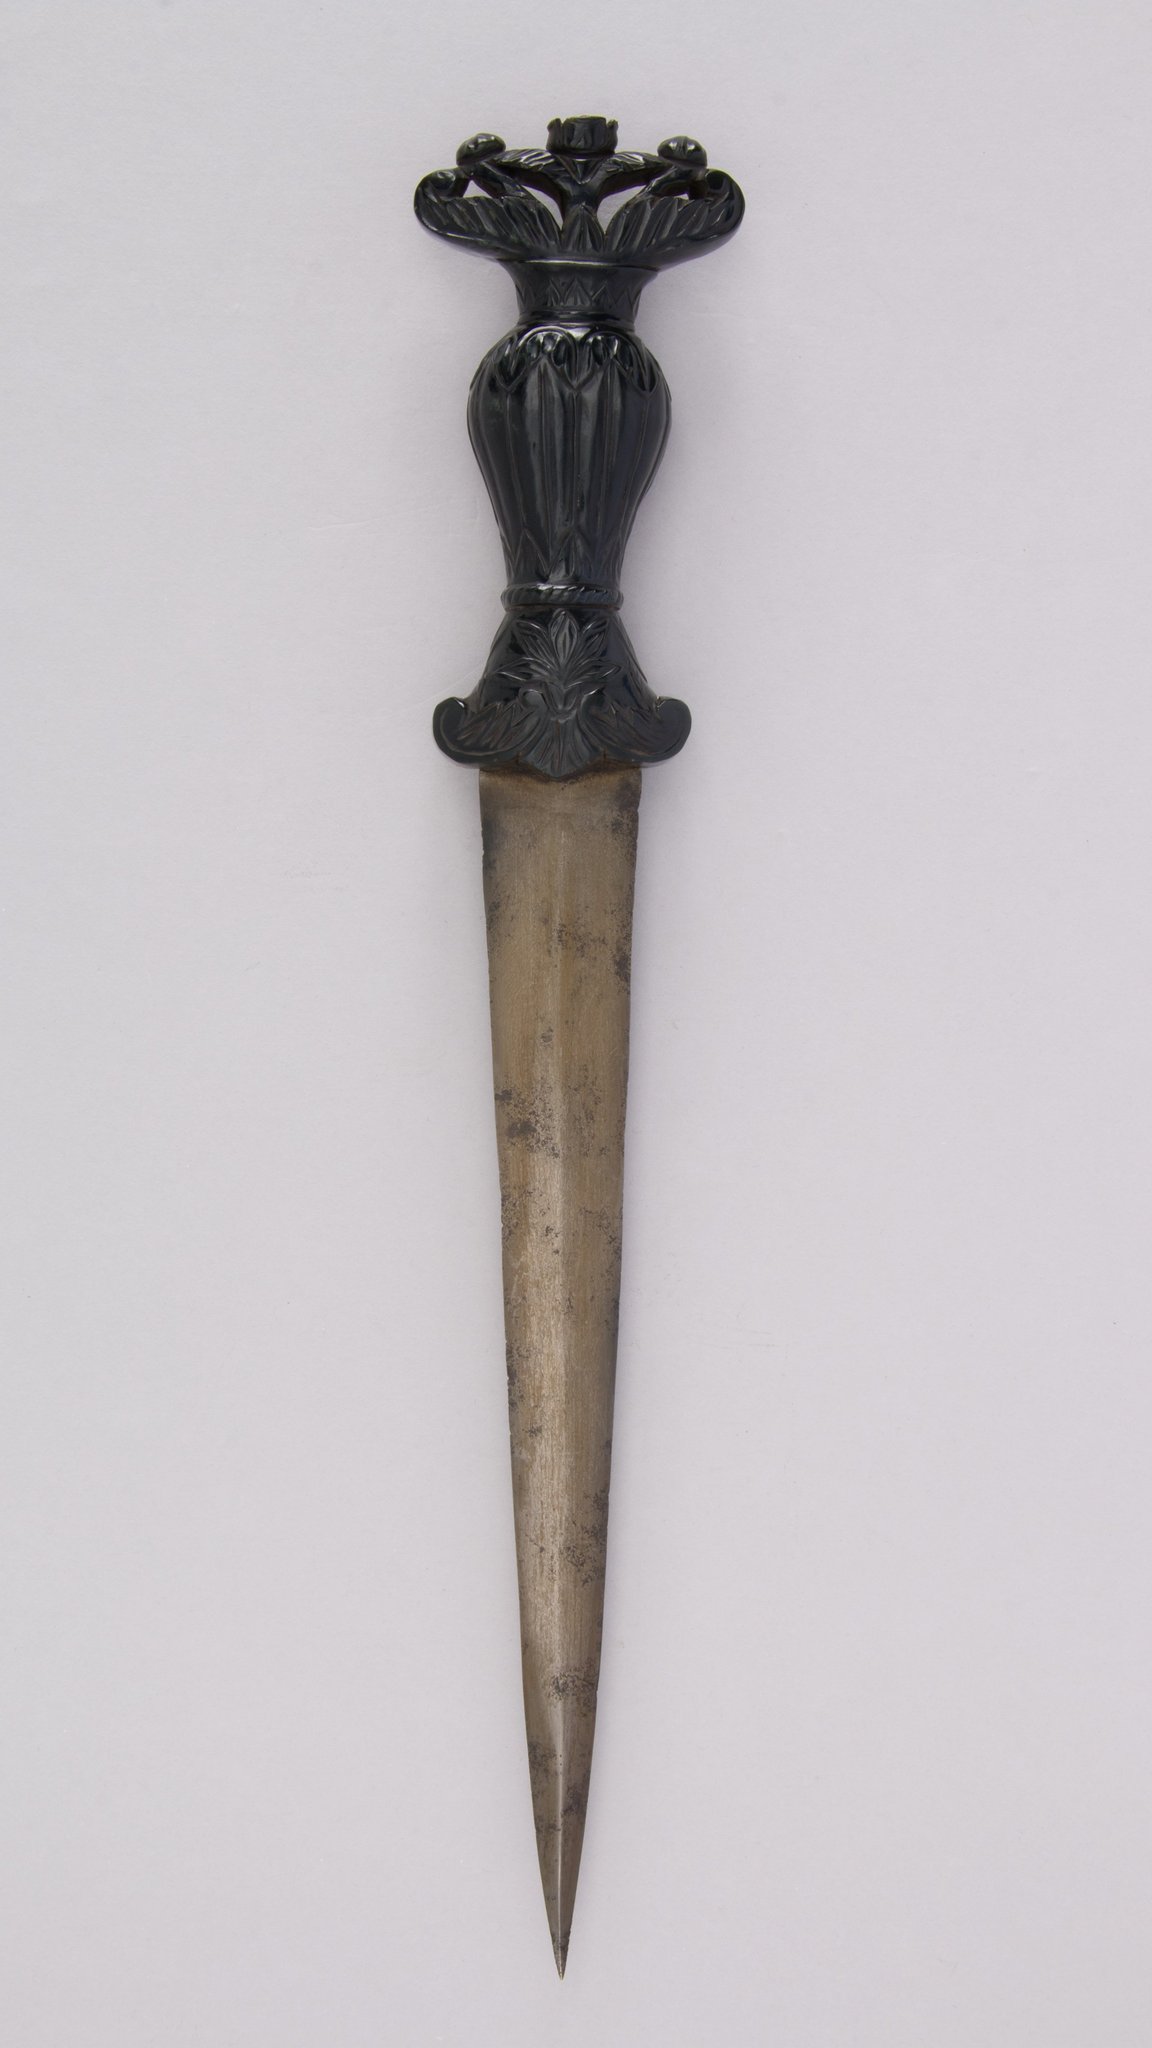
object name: dagger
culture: indian, mughal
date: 1801-1900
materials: gold, jade, gemstone, steel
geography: india